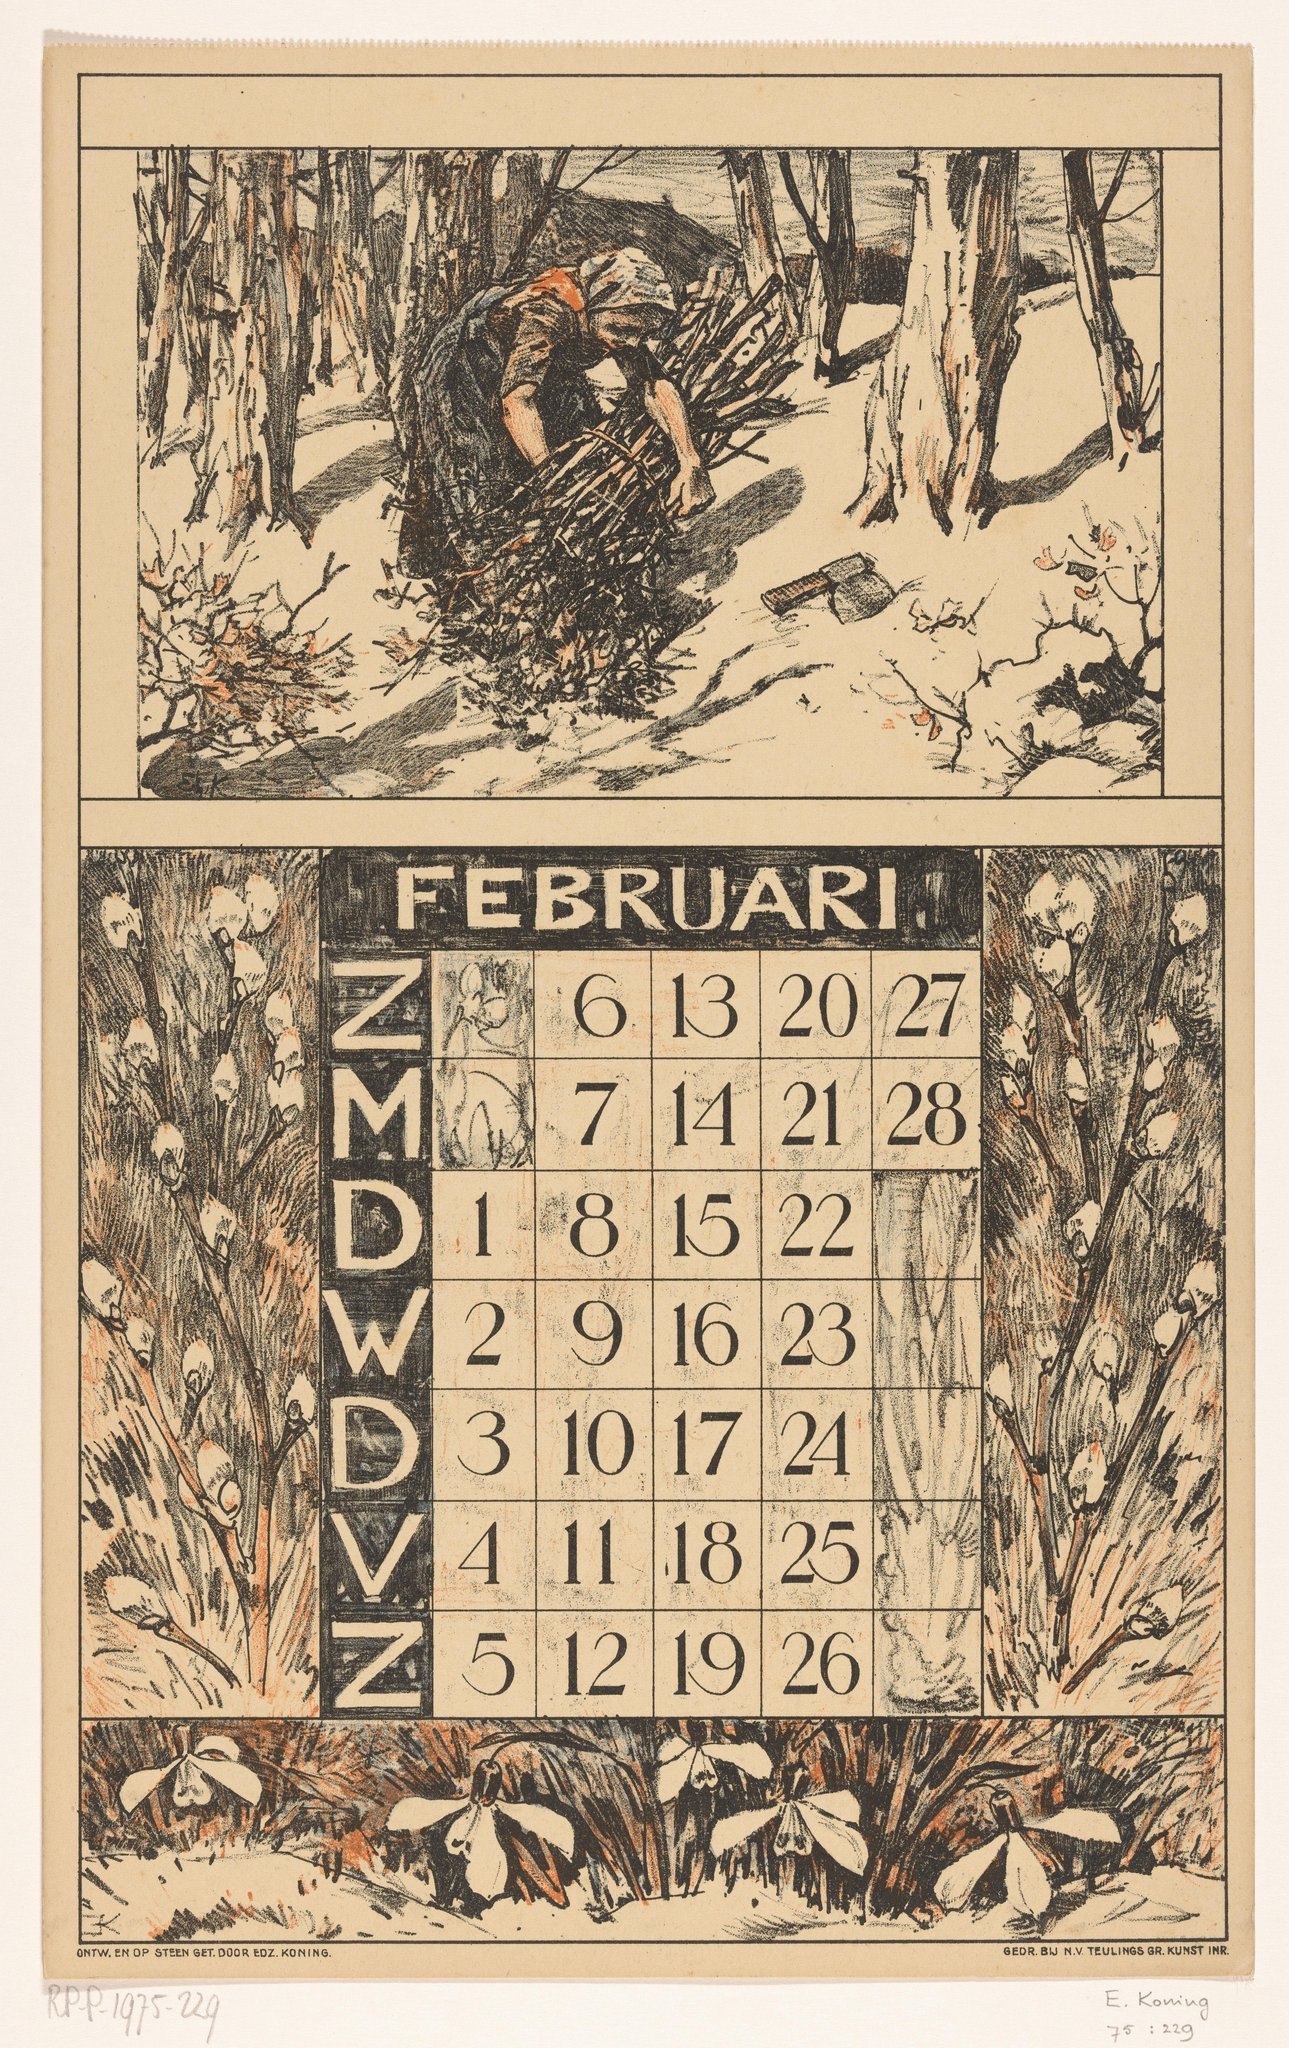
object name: print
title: Kalenderblad voor februari 1921 van de Nederlandsche Gist- en Spiritusfabriek in Delft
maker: edzard koning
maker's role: draughtsman, print maker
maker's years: 1869-1954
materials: paper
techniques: lithograph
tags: flowers, woodgathering, woodgatherer, trees: willow (+ branch, stick), snow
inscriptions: collector's mark: Lugt 2228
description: Een vierkant kader opgevuld met de dagen van de maand februari en daaromheen takken met wilgenkatjes en sneeuwklokjes. Bovenaan een rechthoekig kader met daarin een vrouw die een bundel takken optilt in een besneeuwd bos. Er ligt een bijl in de sneeuw naast haar.